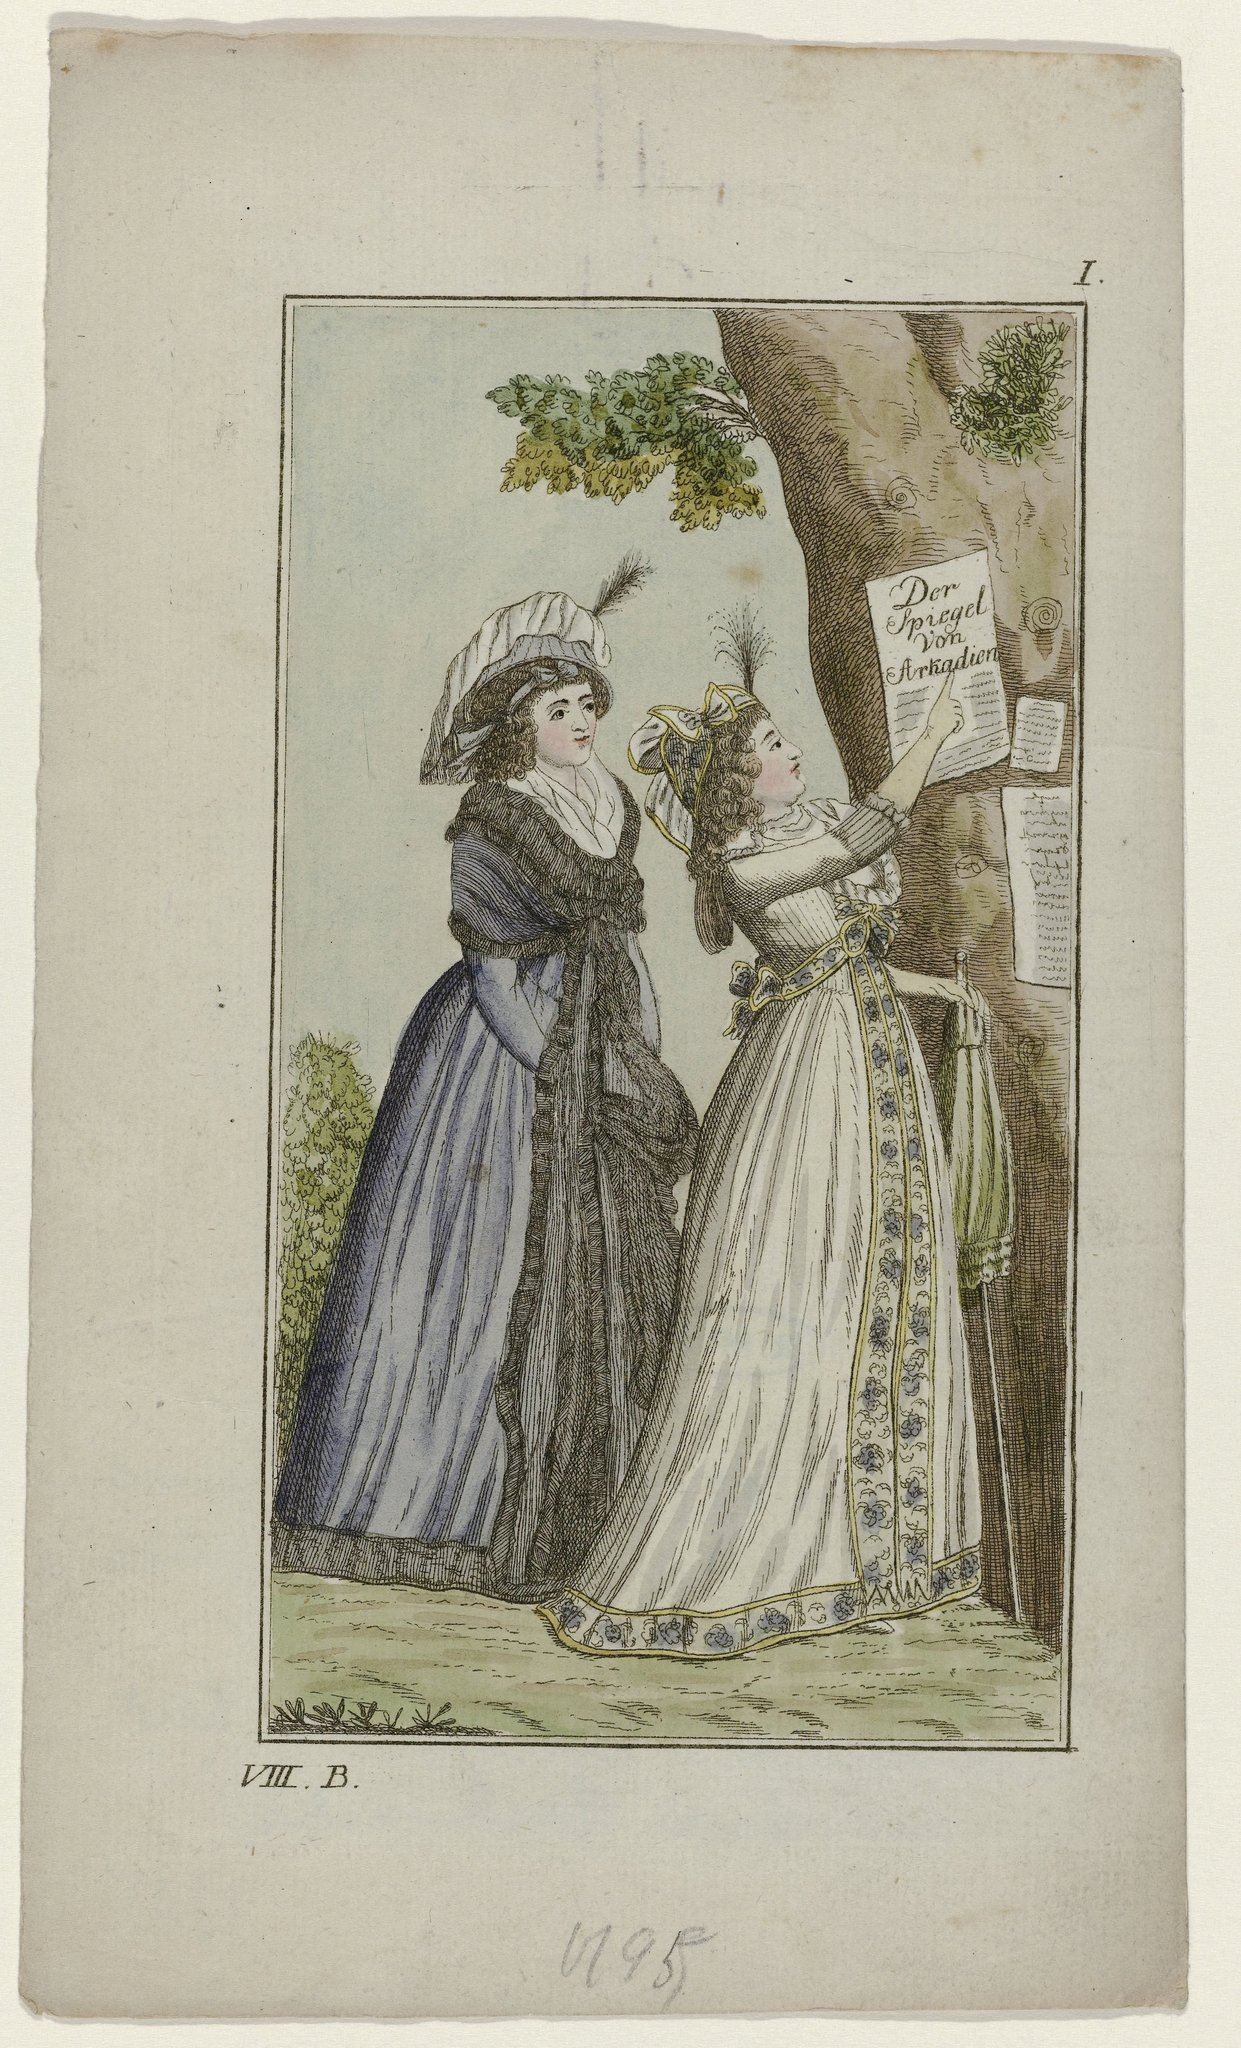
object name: fashion print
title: Berlinisches archiv der Zeit und ihres geschmacks, 1795, VIII.B, I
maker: Anonymous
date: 1795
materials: paper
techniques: etching, hand coloring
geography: berlin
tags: clothing for the upper part of the body (+ women's clothes), gloves, mittens (long gloves) (+ women's clothes), walking-stick, staff, cane (+ variant), head-gear: cap (+ women's clothes), fashion plates, dress, gown (+ women's clothes), piece of clothing covering the breast or décolleté (fichu) (+ women's clothes), poster, parasol, sunshade (+ women's clothes)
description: Twee staande vrouwen bij een boom met aanplakbiljetten. De vrouw links draagt een japon met lange mouwen en een kleine schoudermantel . Fichu. Op het hoofd een muts. De andere vrouw draagt een japon, afgezet met sierband. Fichu. In de linkerhand een wandelstok, die ook als parasol kan worden gebruikt. Verdere accessoires: muts (?) met veer, lange handschoenen. Uit het modetijdschrift Berlinisches archiv der Zeit und ihres geschmacks, 1795-1800.